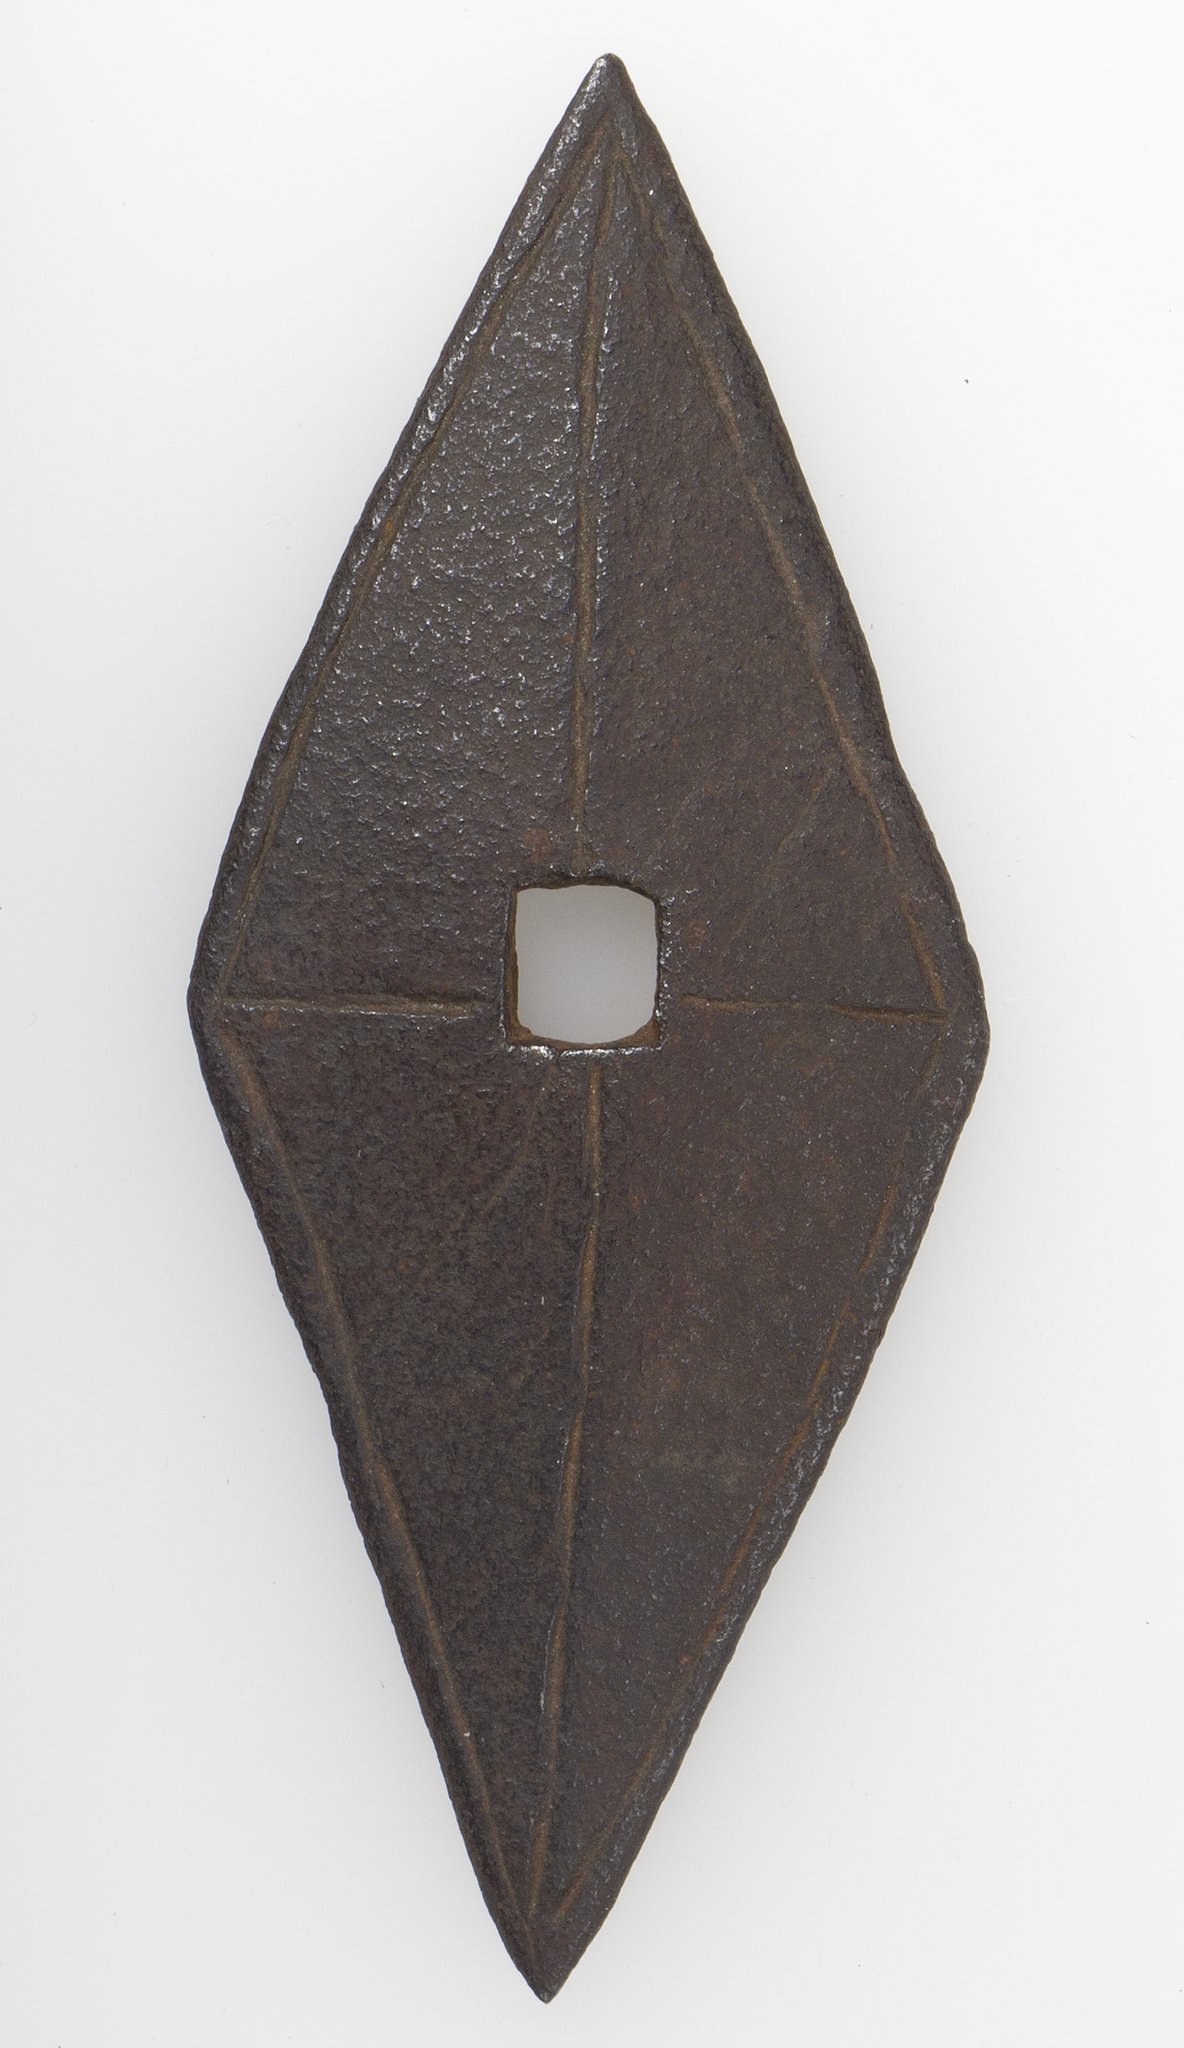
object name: plate and nail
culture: european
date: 1401-1600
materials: iron